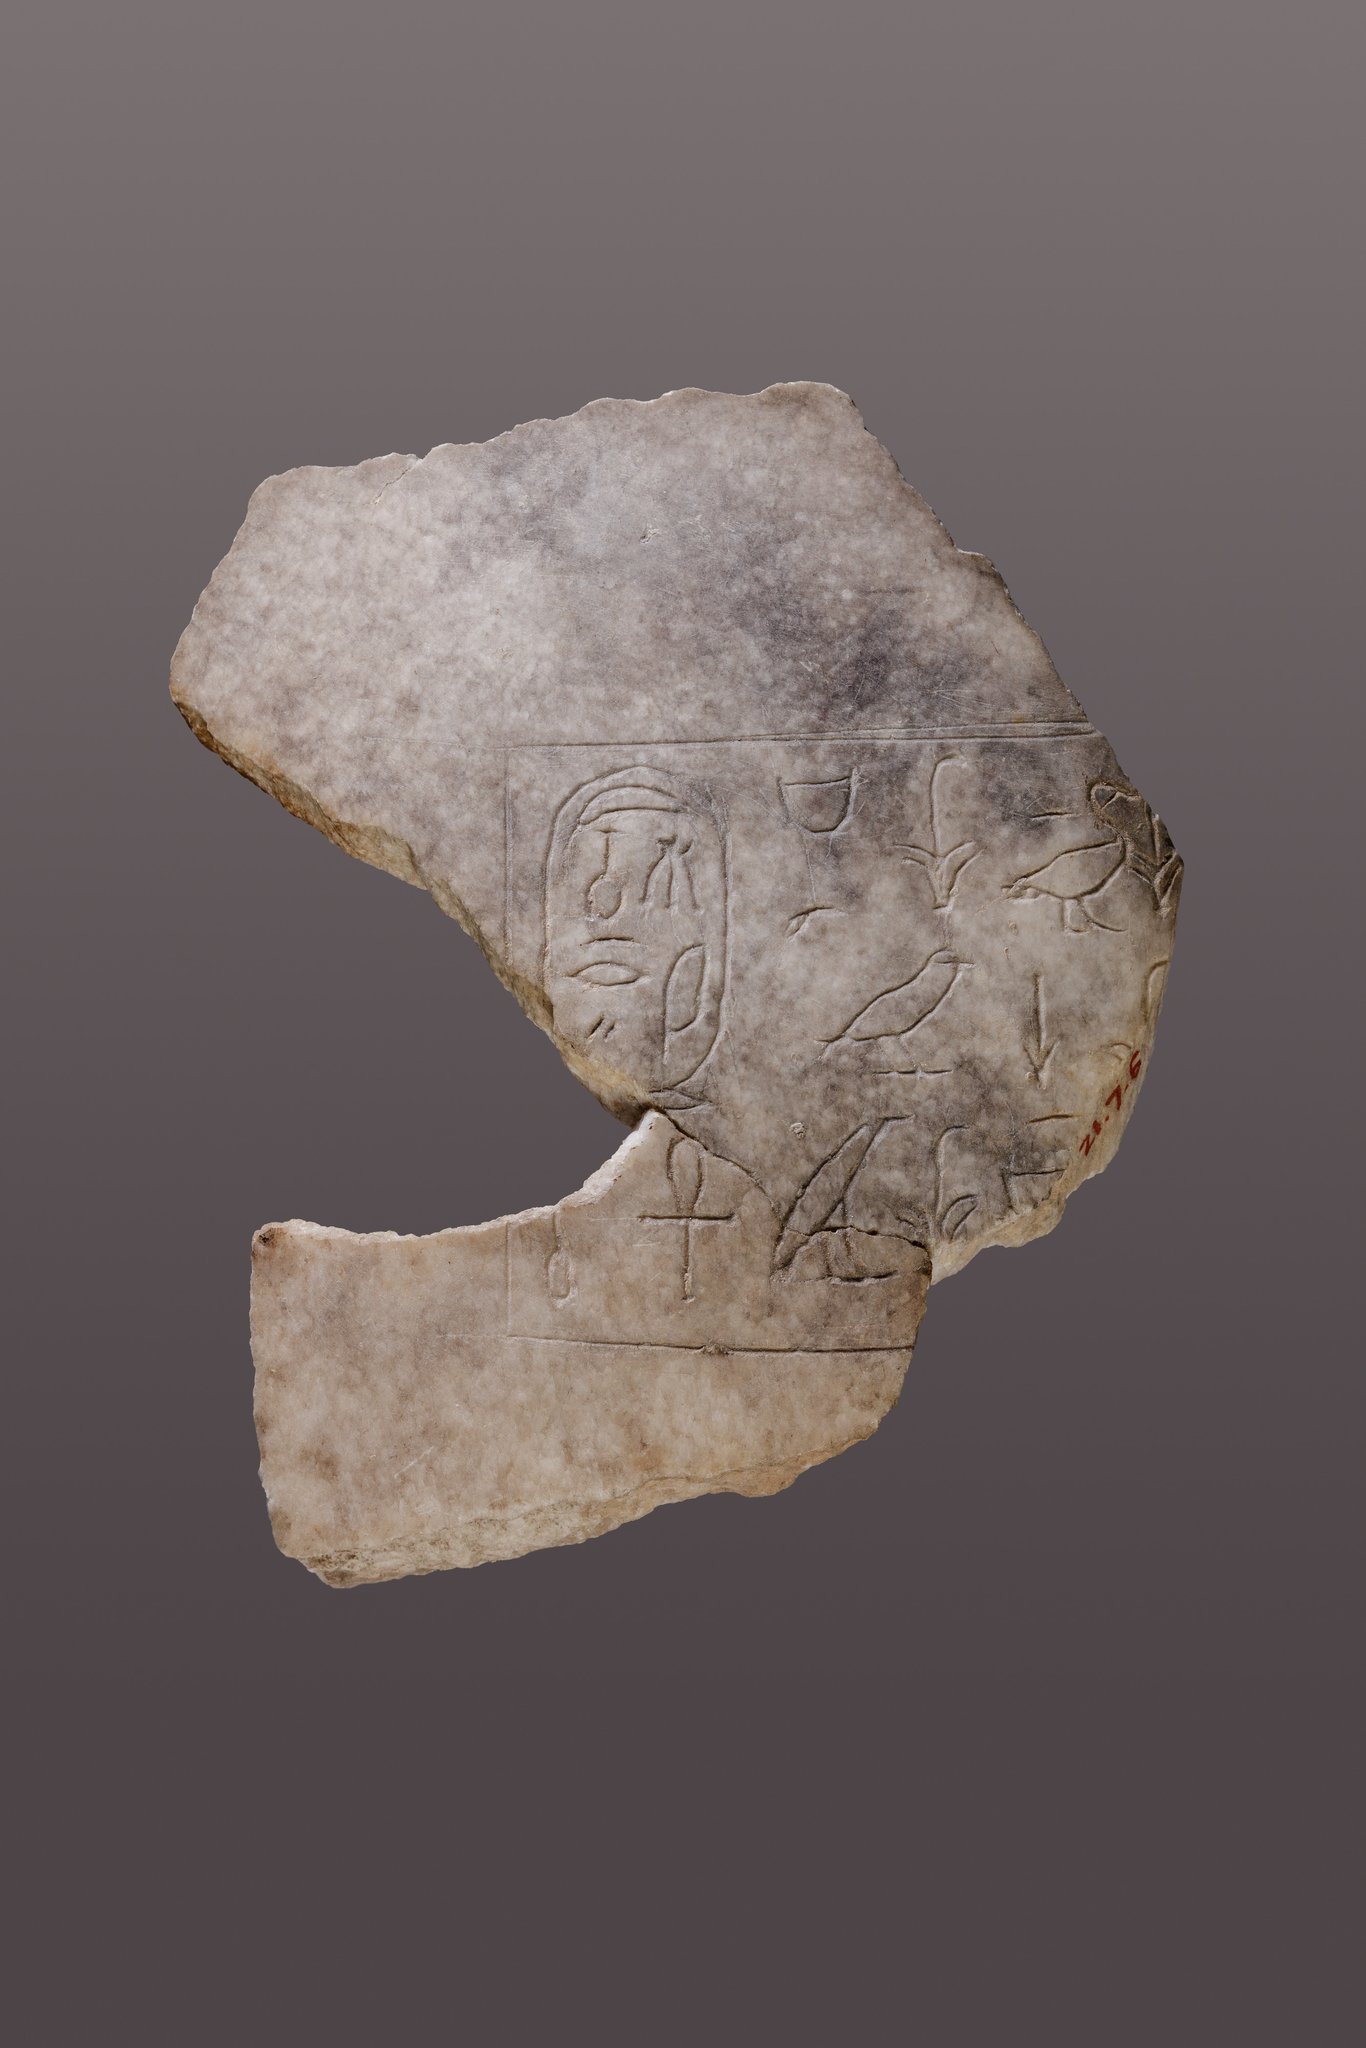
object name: jar fragment, ahmose nefertari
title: Jar fragment, Ahmose-Nefertari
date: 1525-1504 BCE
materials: stone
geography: egypt